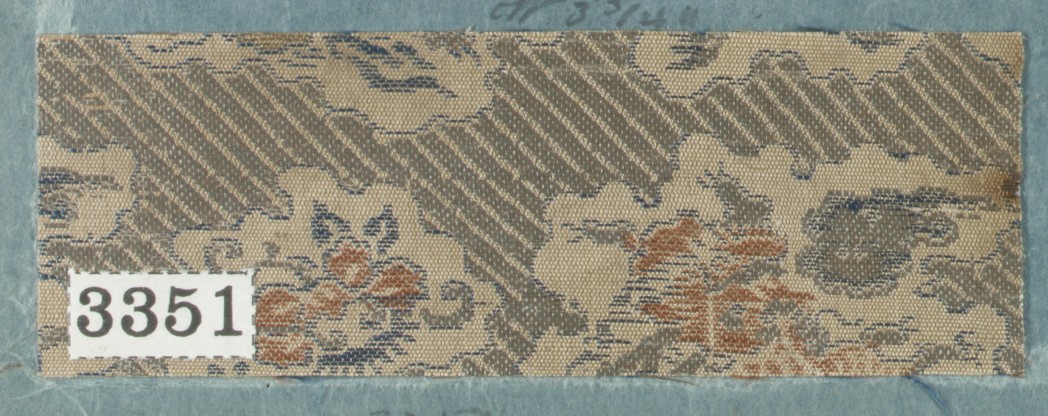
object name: textile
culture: japanese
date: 1801-1900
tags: flowers